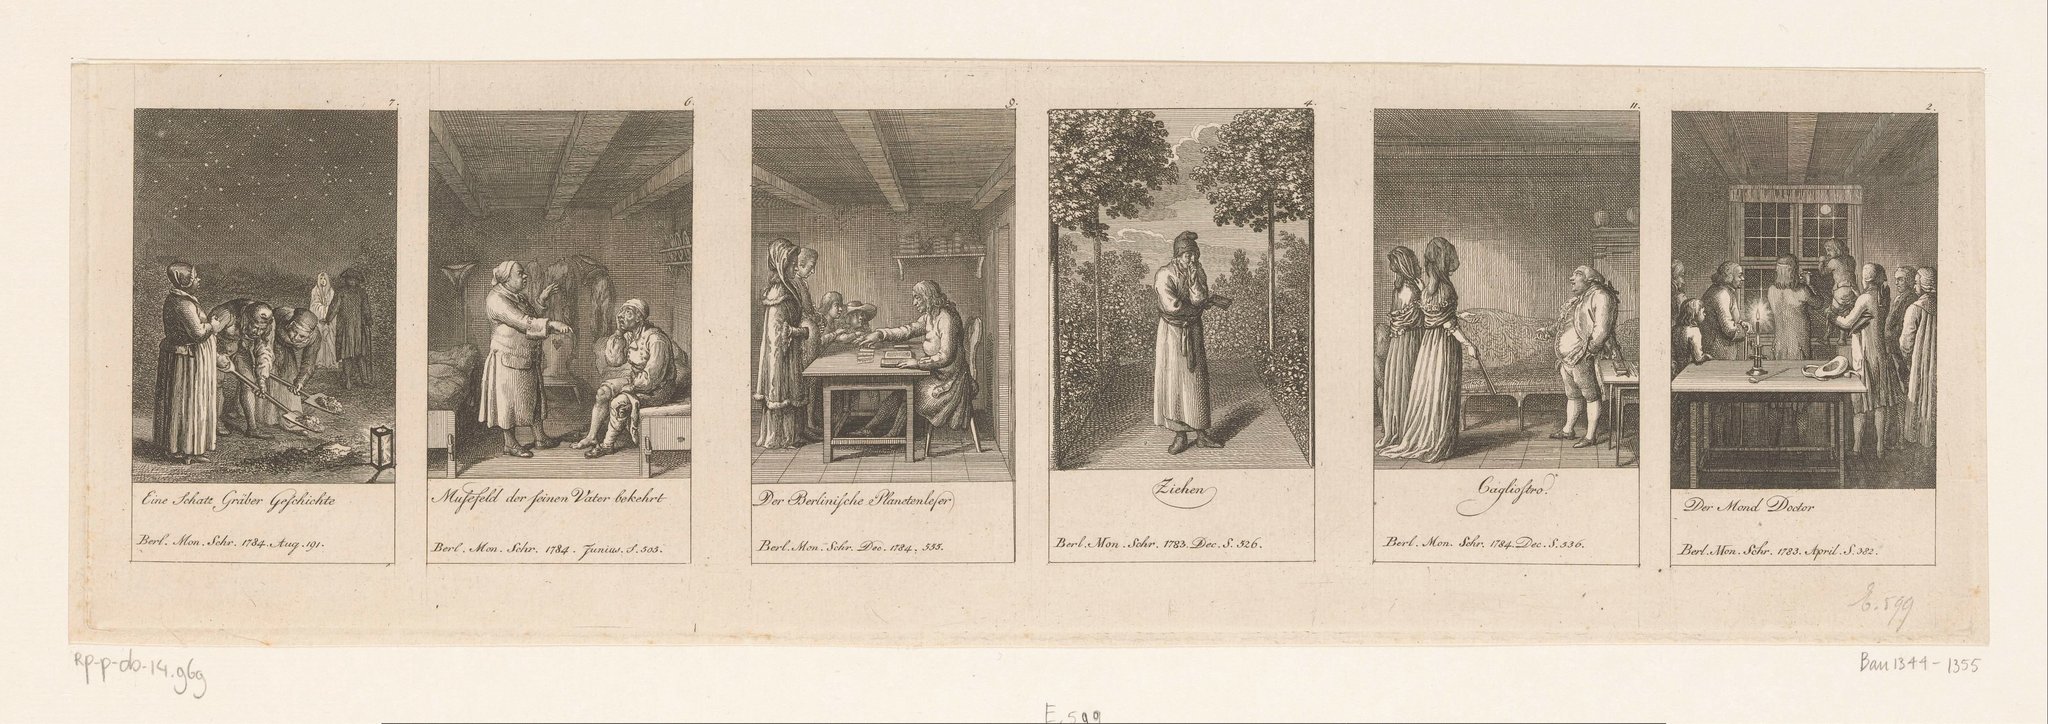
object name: print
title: Zes voorstellingen uit de serie Berlijnse rages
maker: daniel nikolaus chodowiecki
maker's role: draughtsman, print maker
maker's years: 1726-1801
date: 1788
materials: paper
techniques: etching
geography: berlin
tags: treasure hunting, goldrush, full moon, thinking, thought, reflection; 'pensiero' (ripa), horoscope, human figure at (open) window, seen from inside - aa - feigned window, historical persons, astrologer at work, lantern, cheat, deceit; 'fraude', 'inganno' (ripa), letter, envelope, father and son(s) (family group), night, conversion and belief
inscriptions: collector's mark: Lugt 2228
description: Vervaardigd voor een serie over Duitse rages. Prenten gebruikt voor: Berliner genealogischen Calender auf das Jahr 1789. [Berlijn]: s.n., [1788].